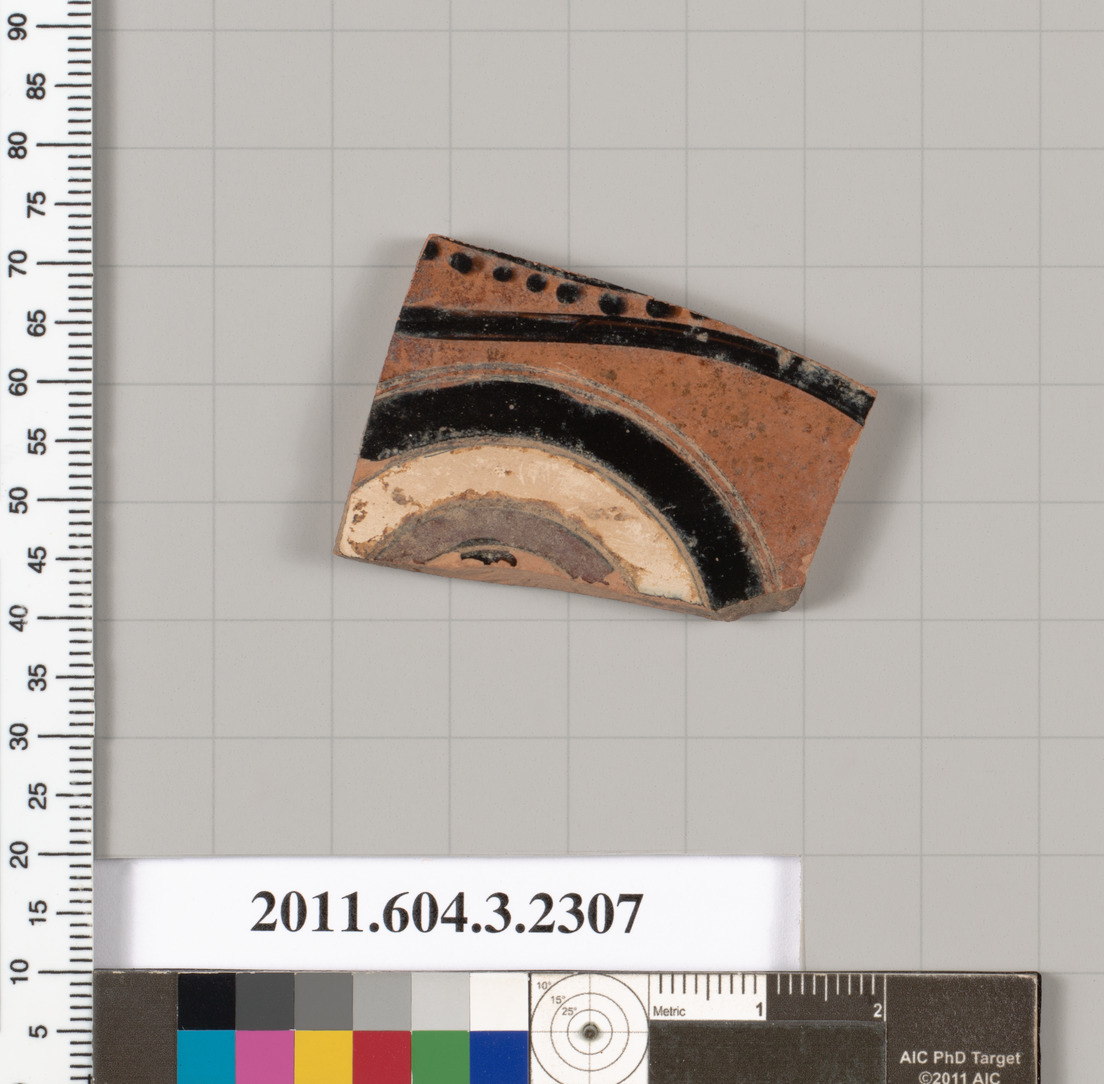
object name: kylix fragment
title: Terracotta fragment of a kylix: eye-cup (drinking cup)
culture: greek, attic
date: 540-520 BCE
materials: terracotta